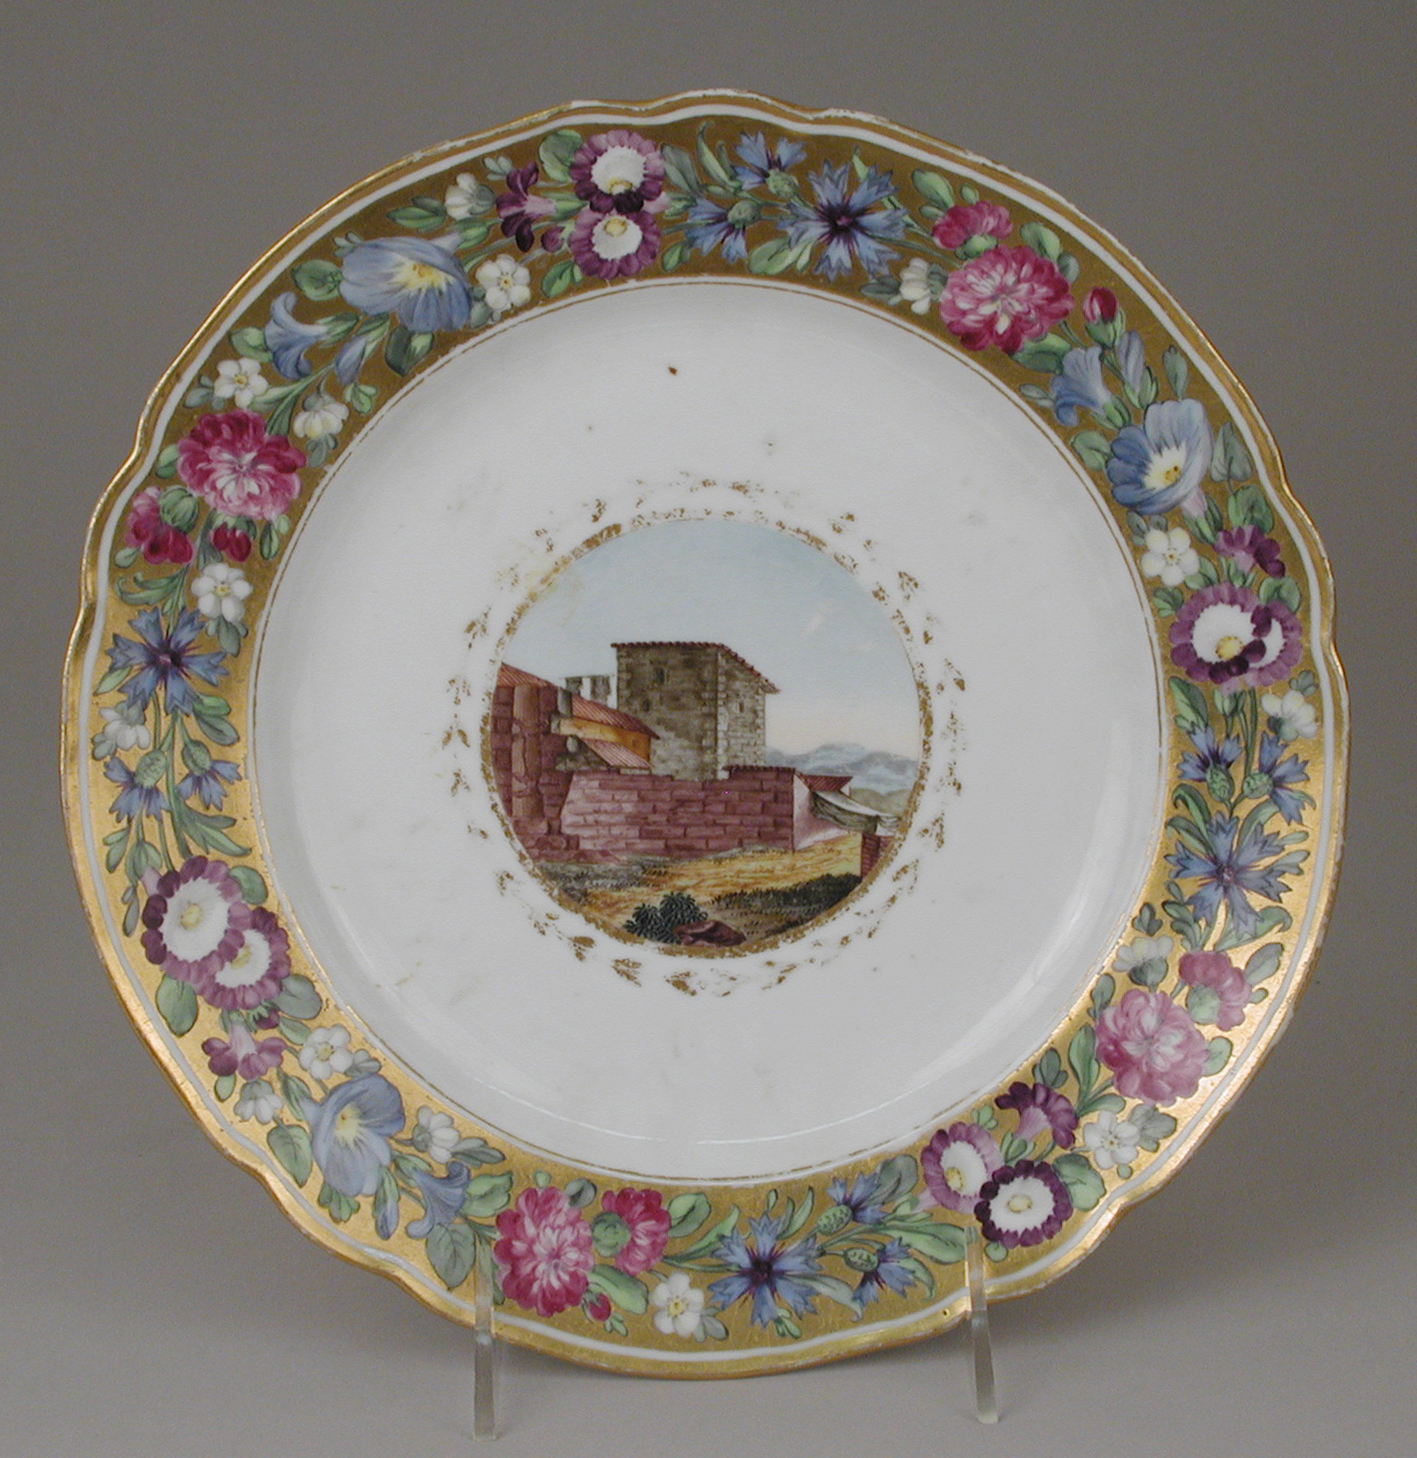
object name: plate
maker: imperial porcelain manufactory, st. petersburg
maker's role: manufactory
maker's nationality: russian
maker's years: 1744-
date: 1796-1801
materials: hard paste porcelain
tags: buildings,flowers